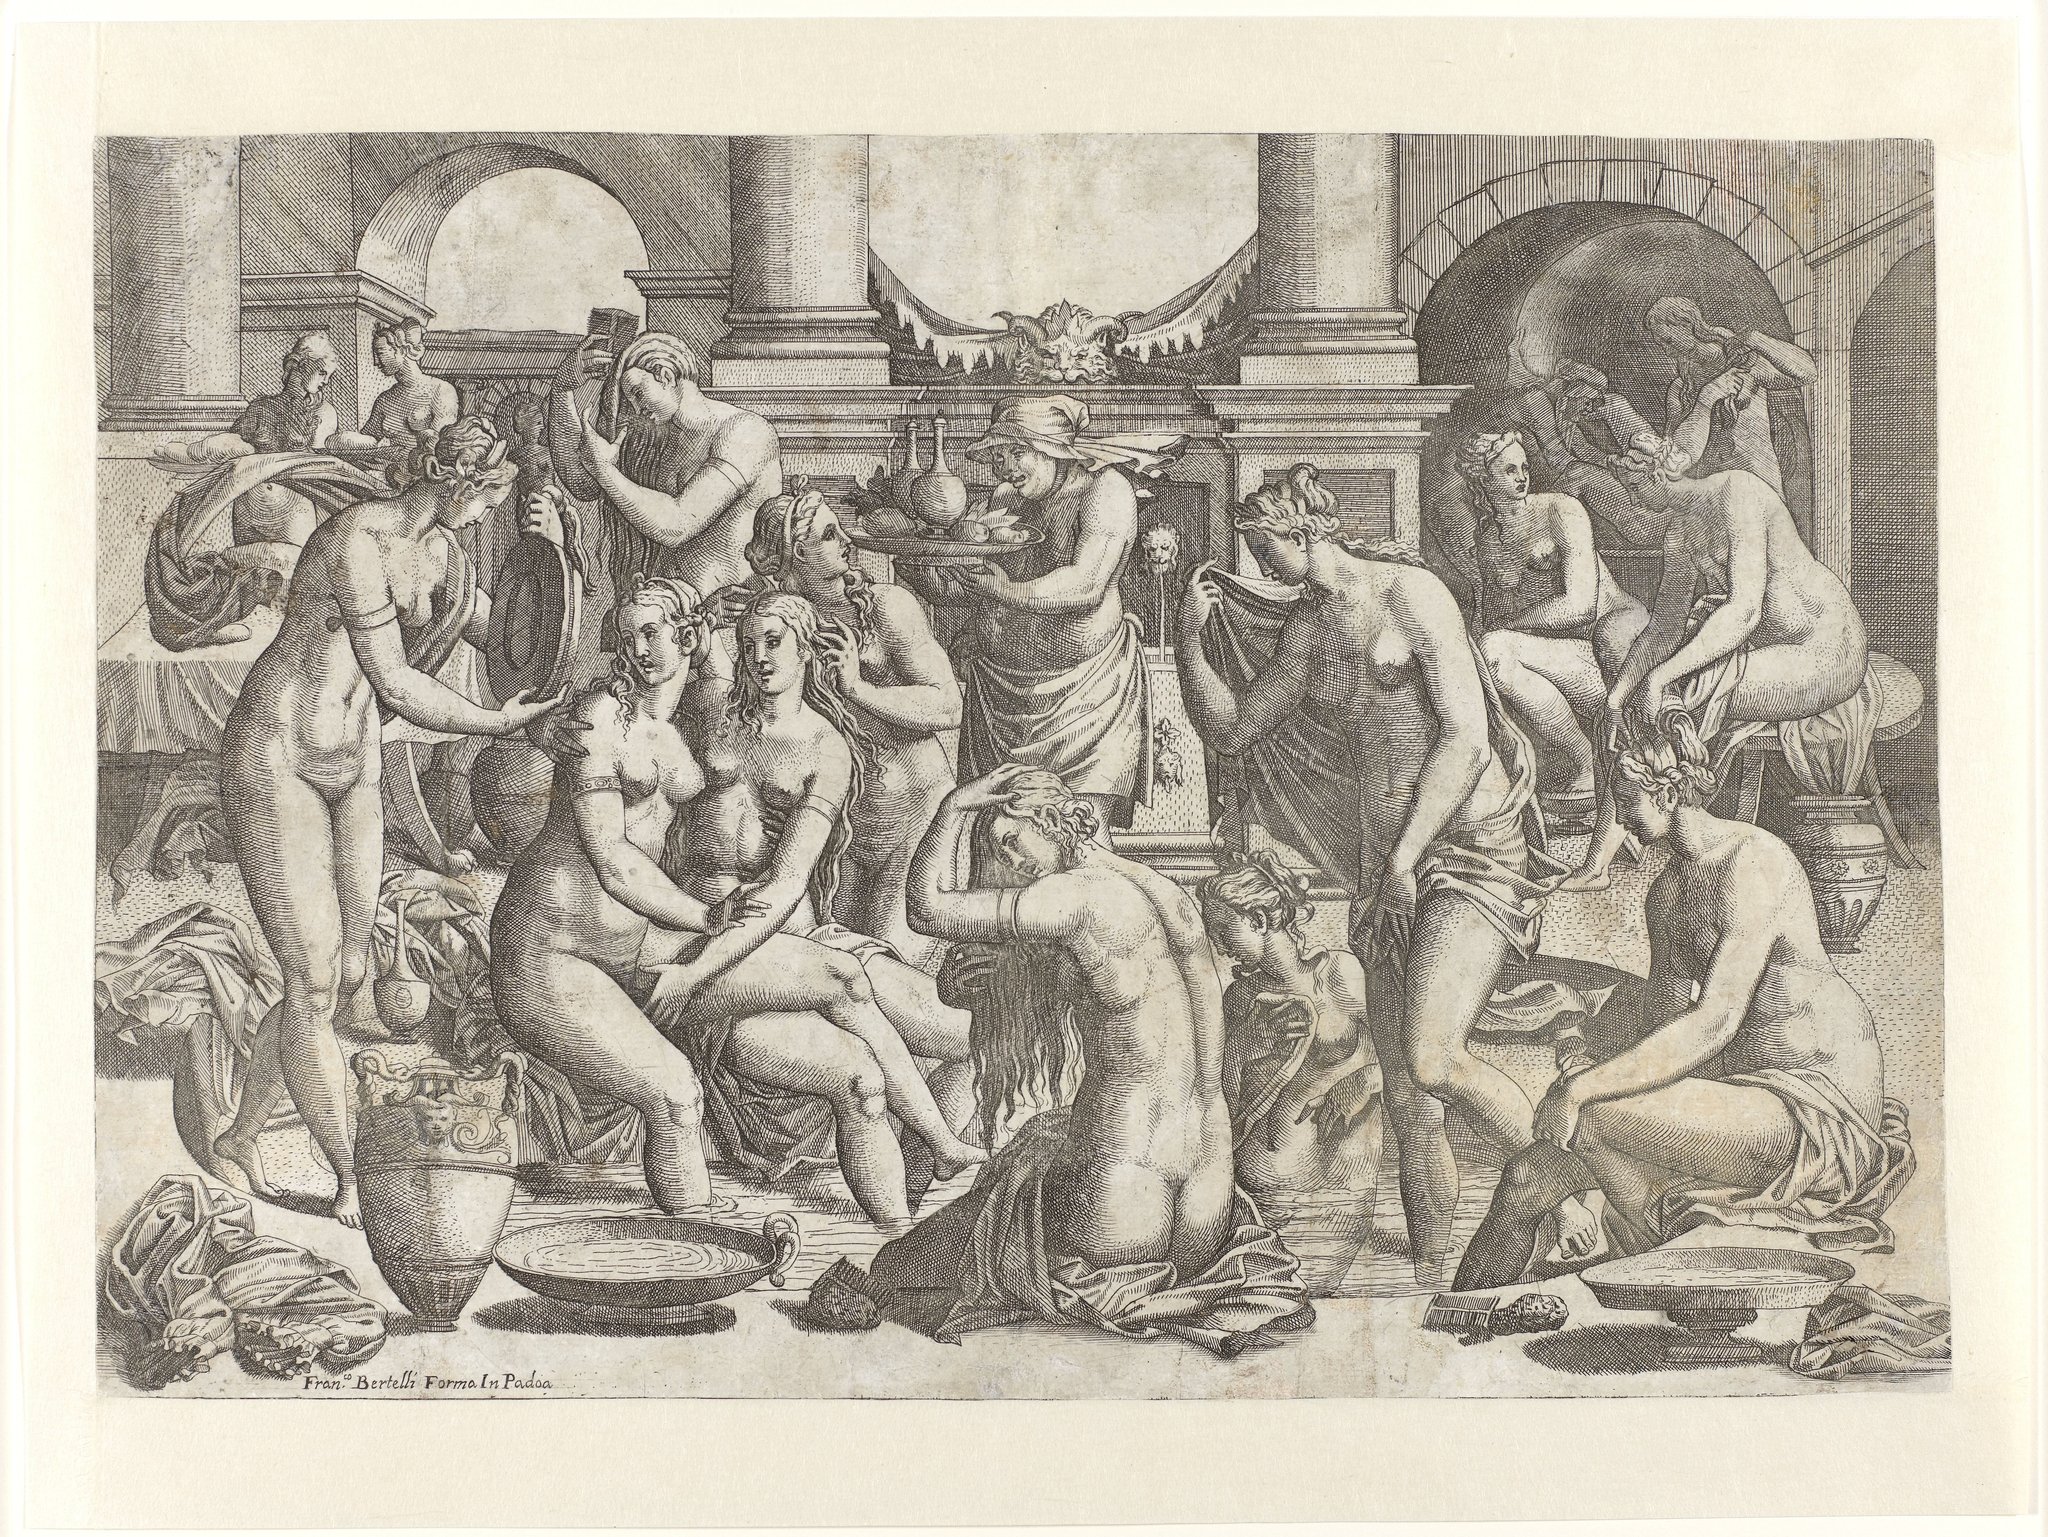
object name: print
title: Badende nimfen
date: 1550-1570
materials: paper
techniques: engraving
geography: padua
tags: nymphs (in general); 'ninfe in commune' (ripa), taking a bath - aa - in the open air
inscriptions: inscription: ‘Fran[ces]co Bertelli forma in Padoa’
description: Een groep badende nimfen in een rond bad in een paleis. Centraal brengt een karikaturale bediende een dienblad met flessen en vruchten. Linksvoor staan een kruik en schaal met water. Rechtsvoor liggen een kam en spons.